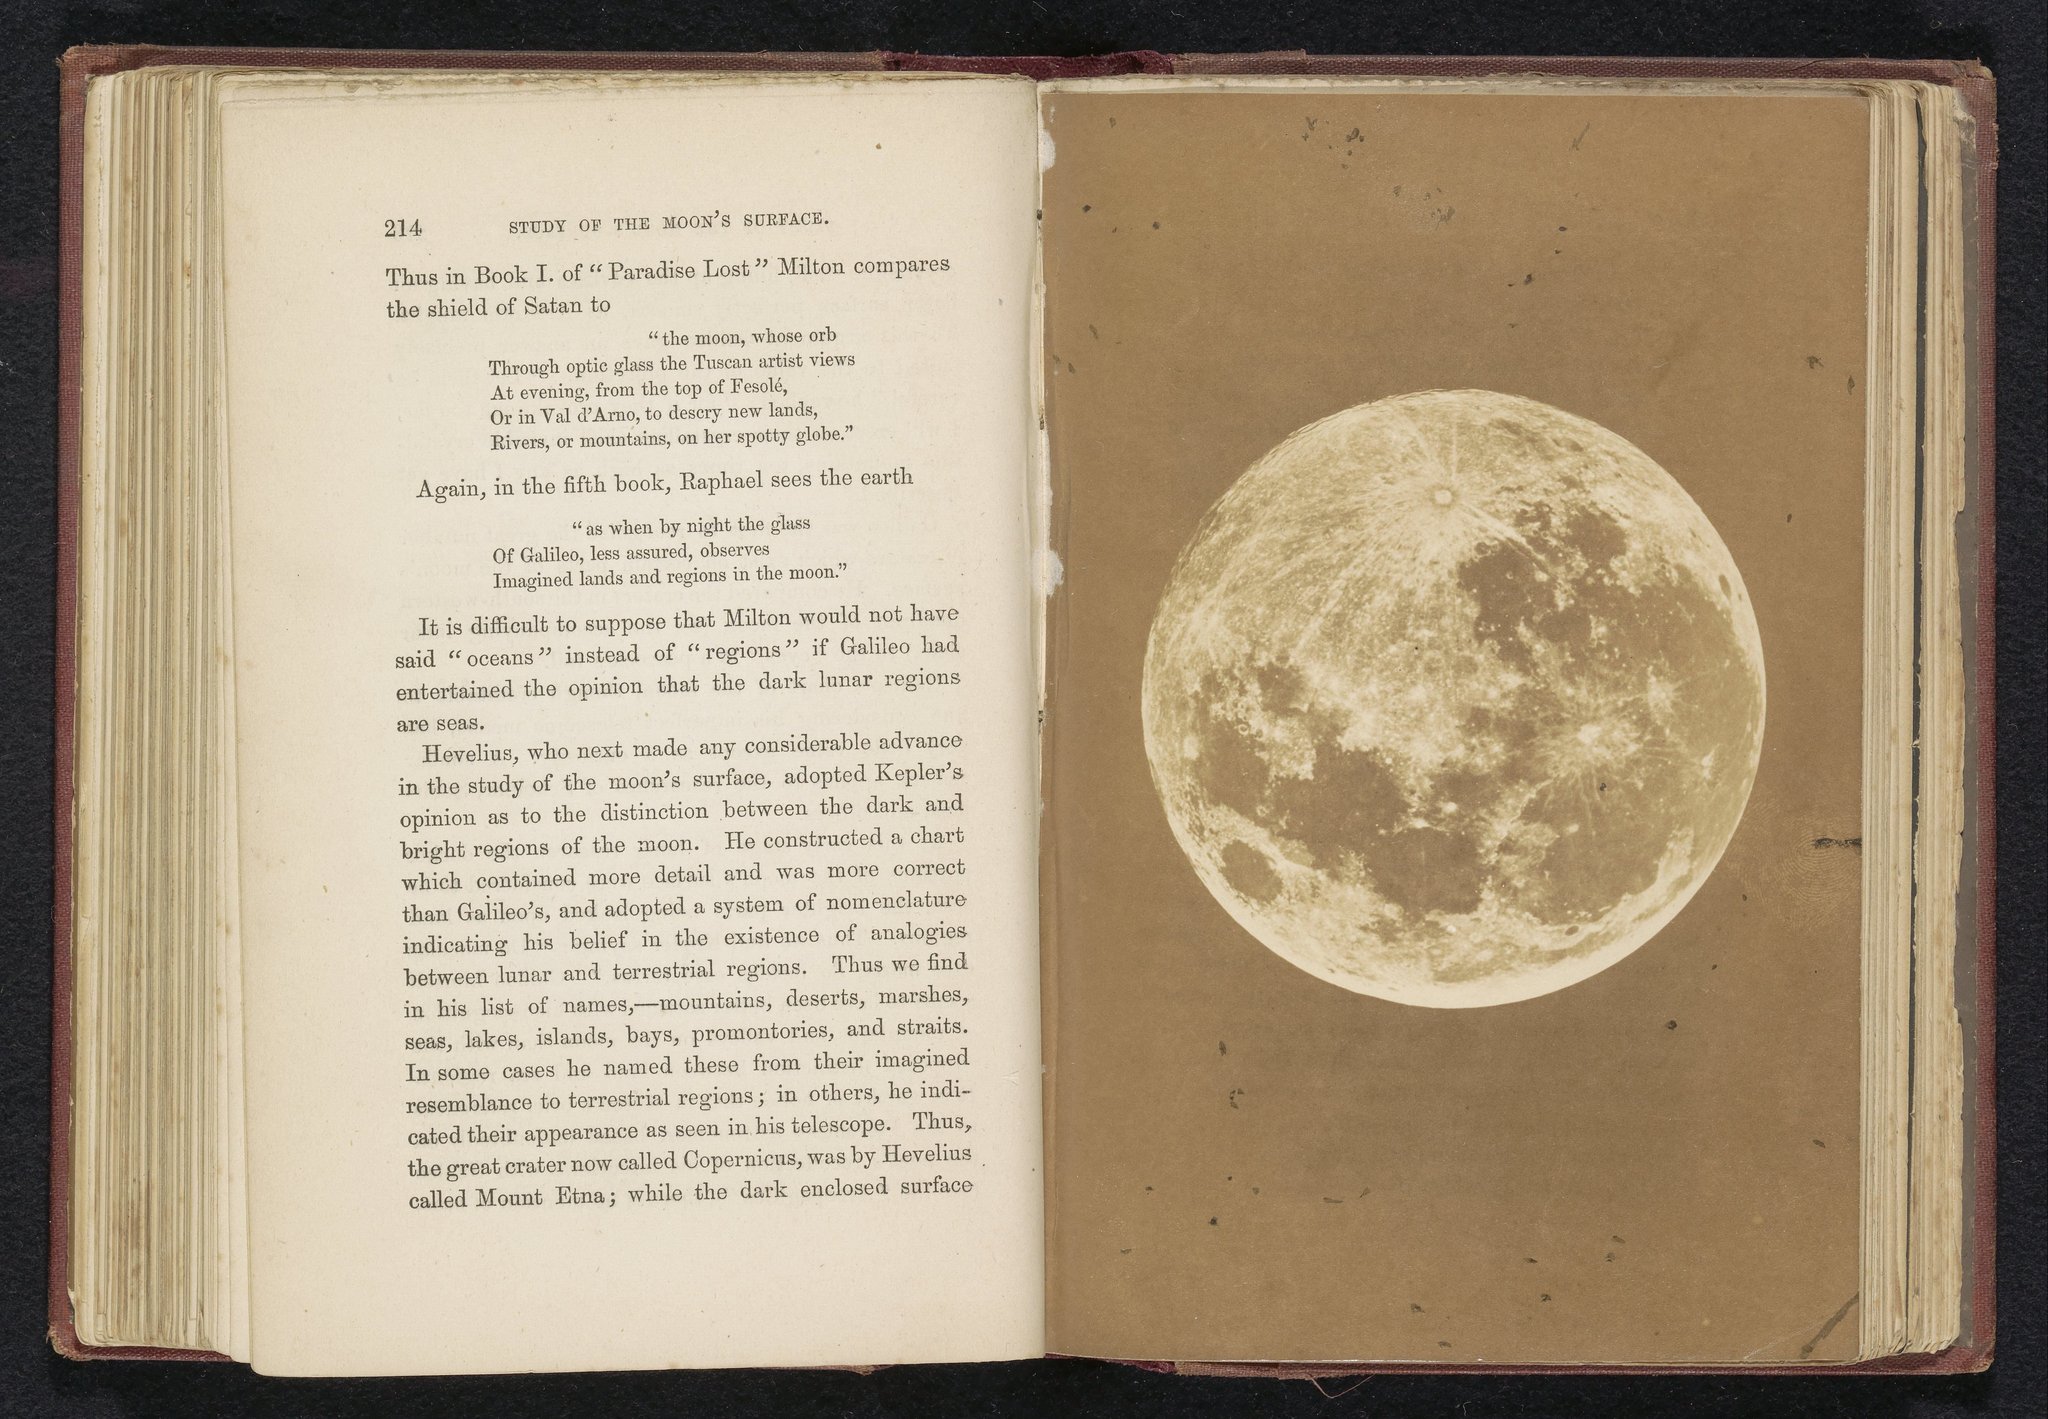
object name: page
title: Volle maan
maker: lewis morris rutherfurd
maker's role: advocaat, astronoom, fotograaf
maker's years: 1816-1892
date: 1863-1873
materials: photographic support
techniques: albumen print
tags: full moon, moon